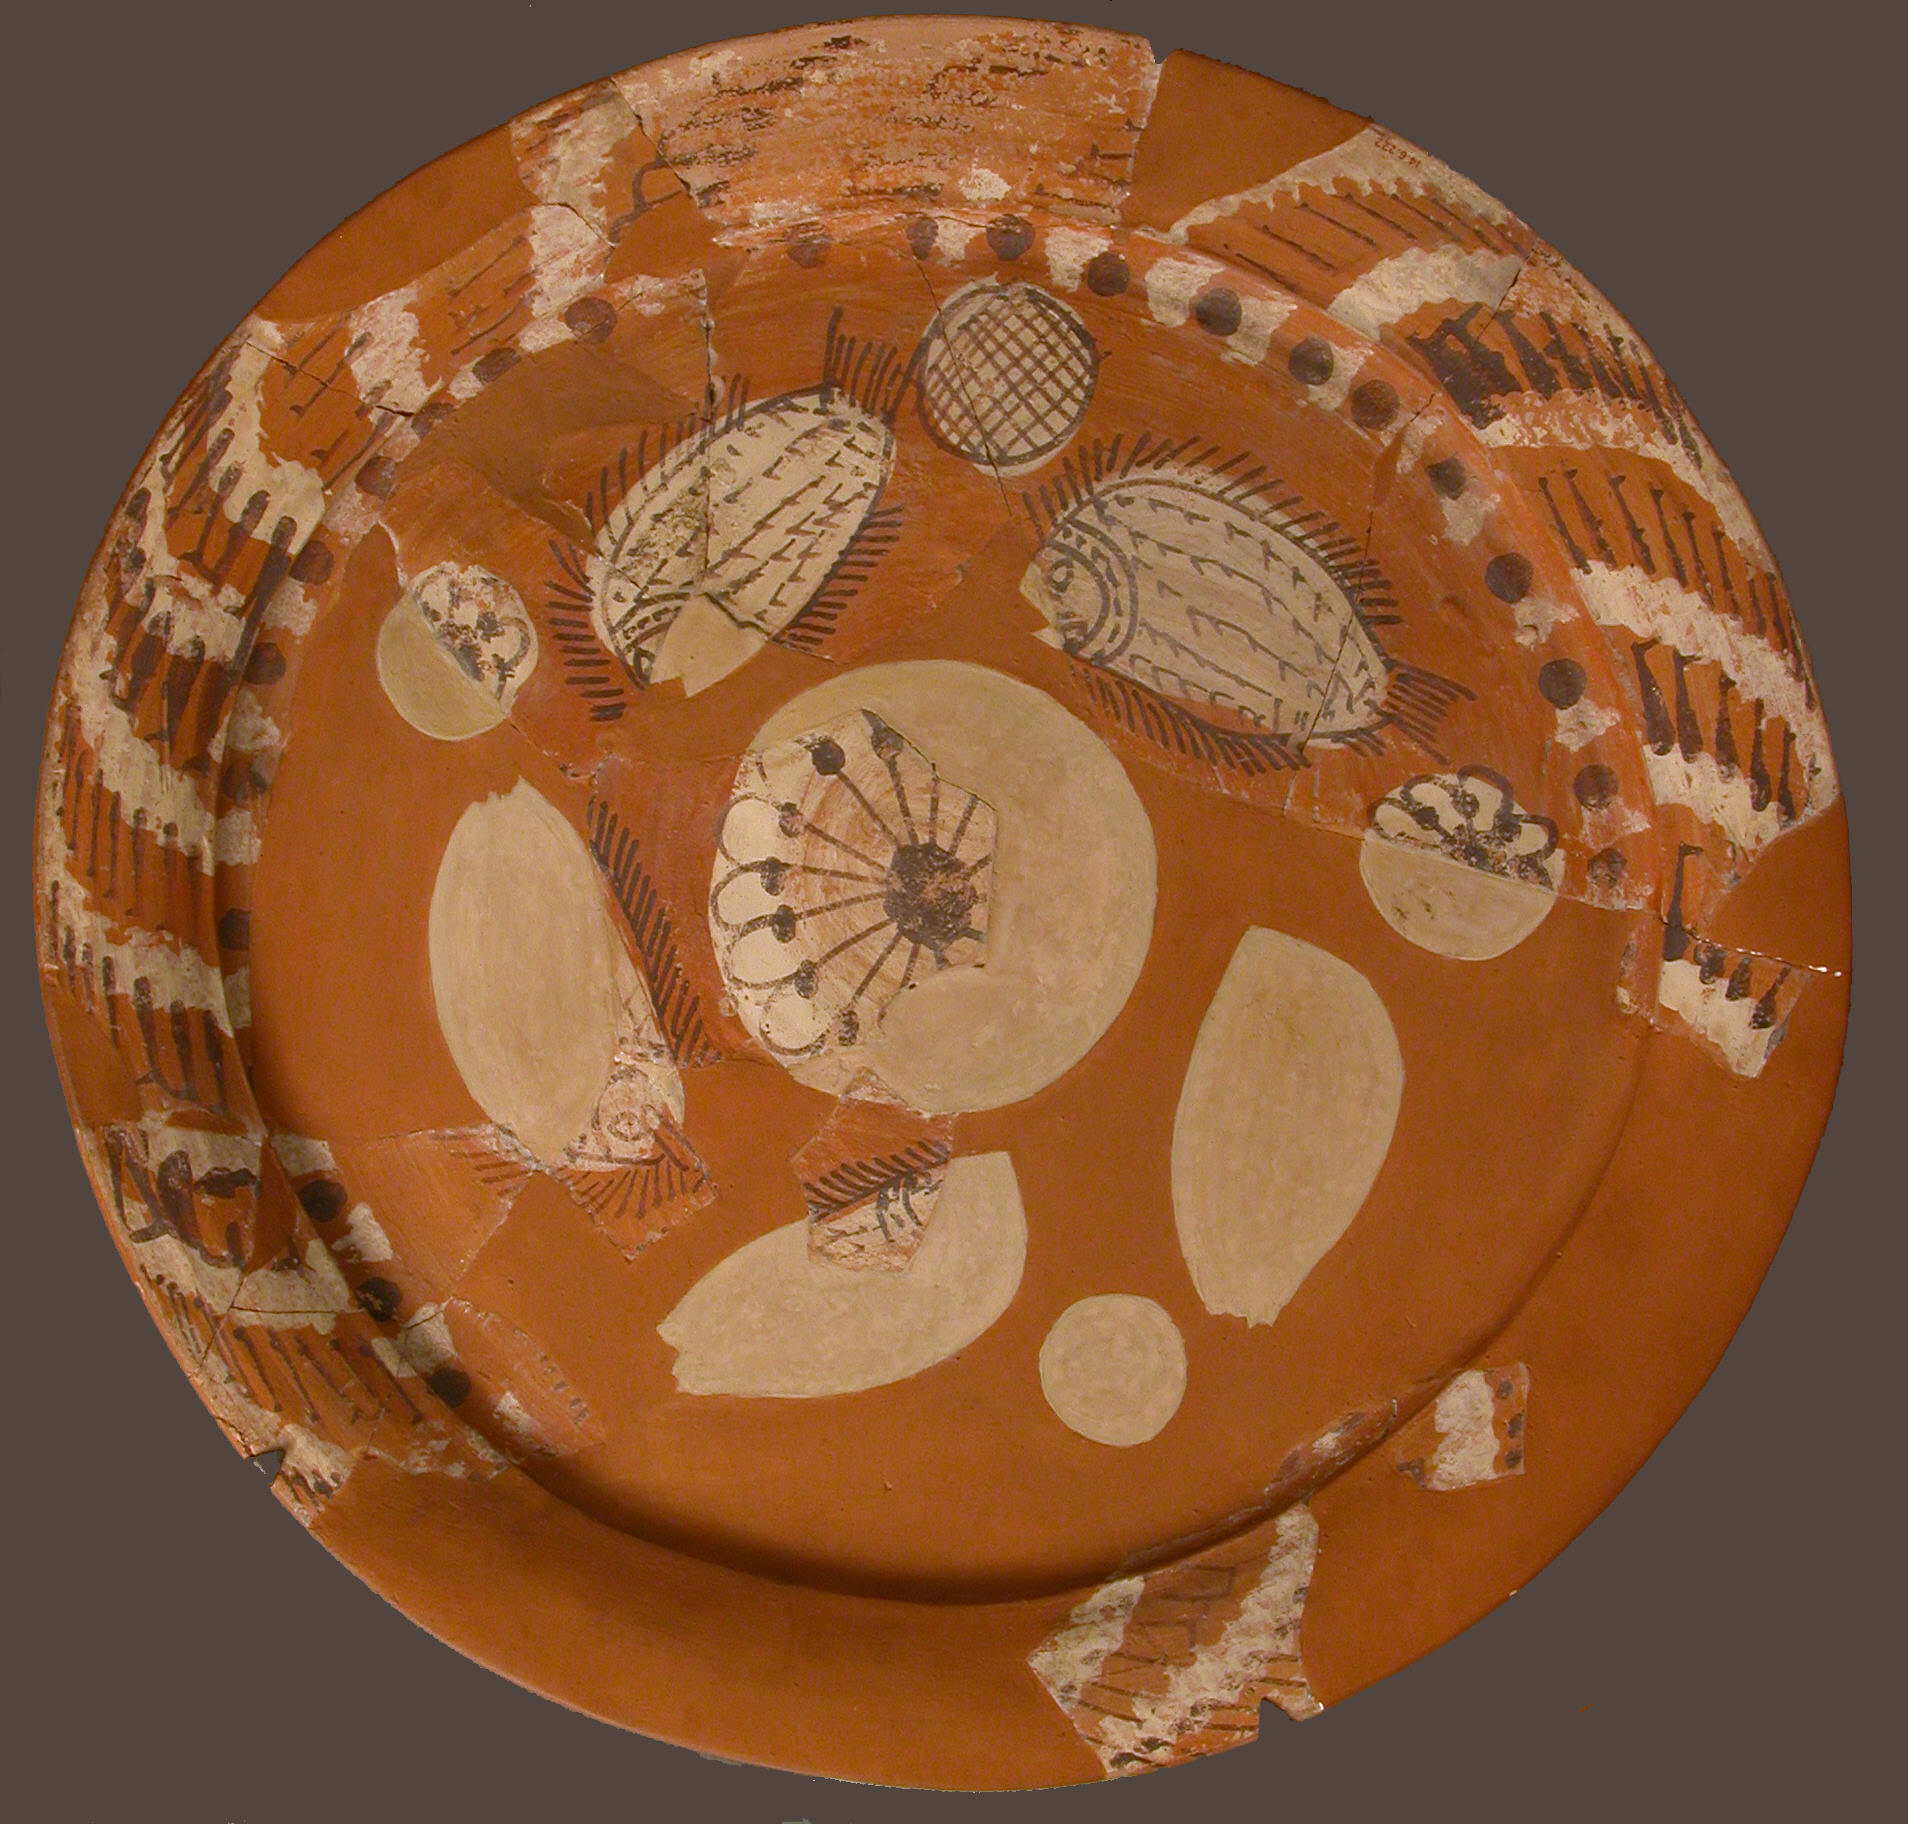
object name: platter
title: Fragmentary Platter with Fish and Rosettes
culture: coptic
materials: terracotta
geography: egypt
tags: fish